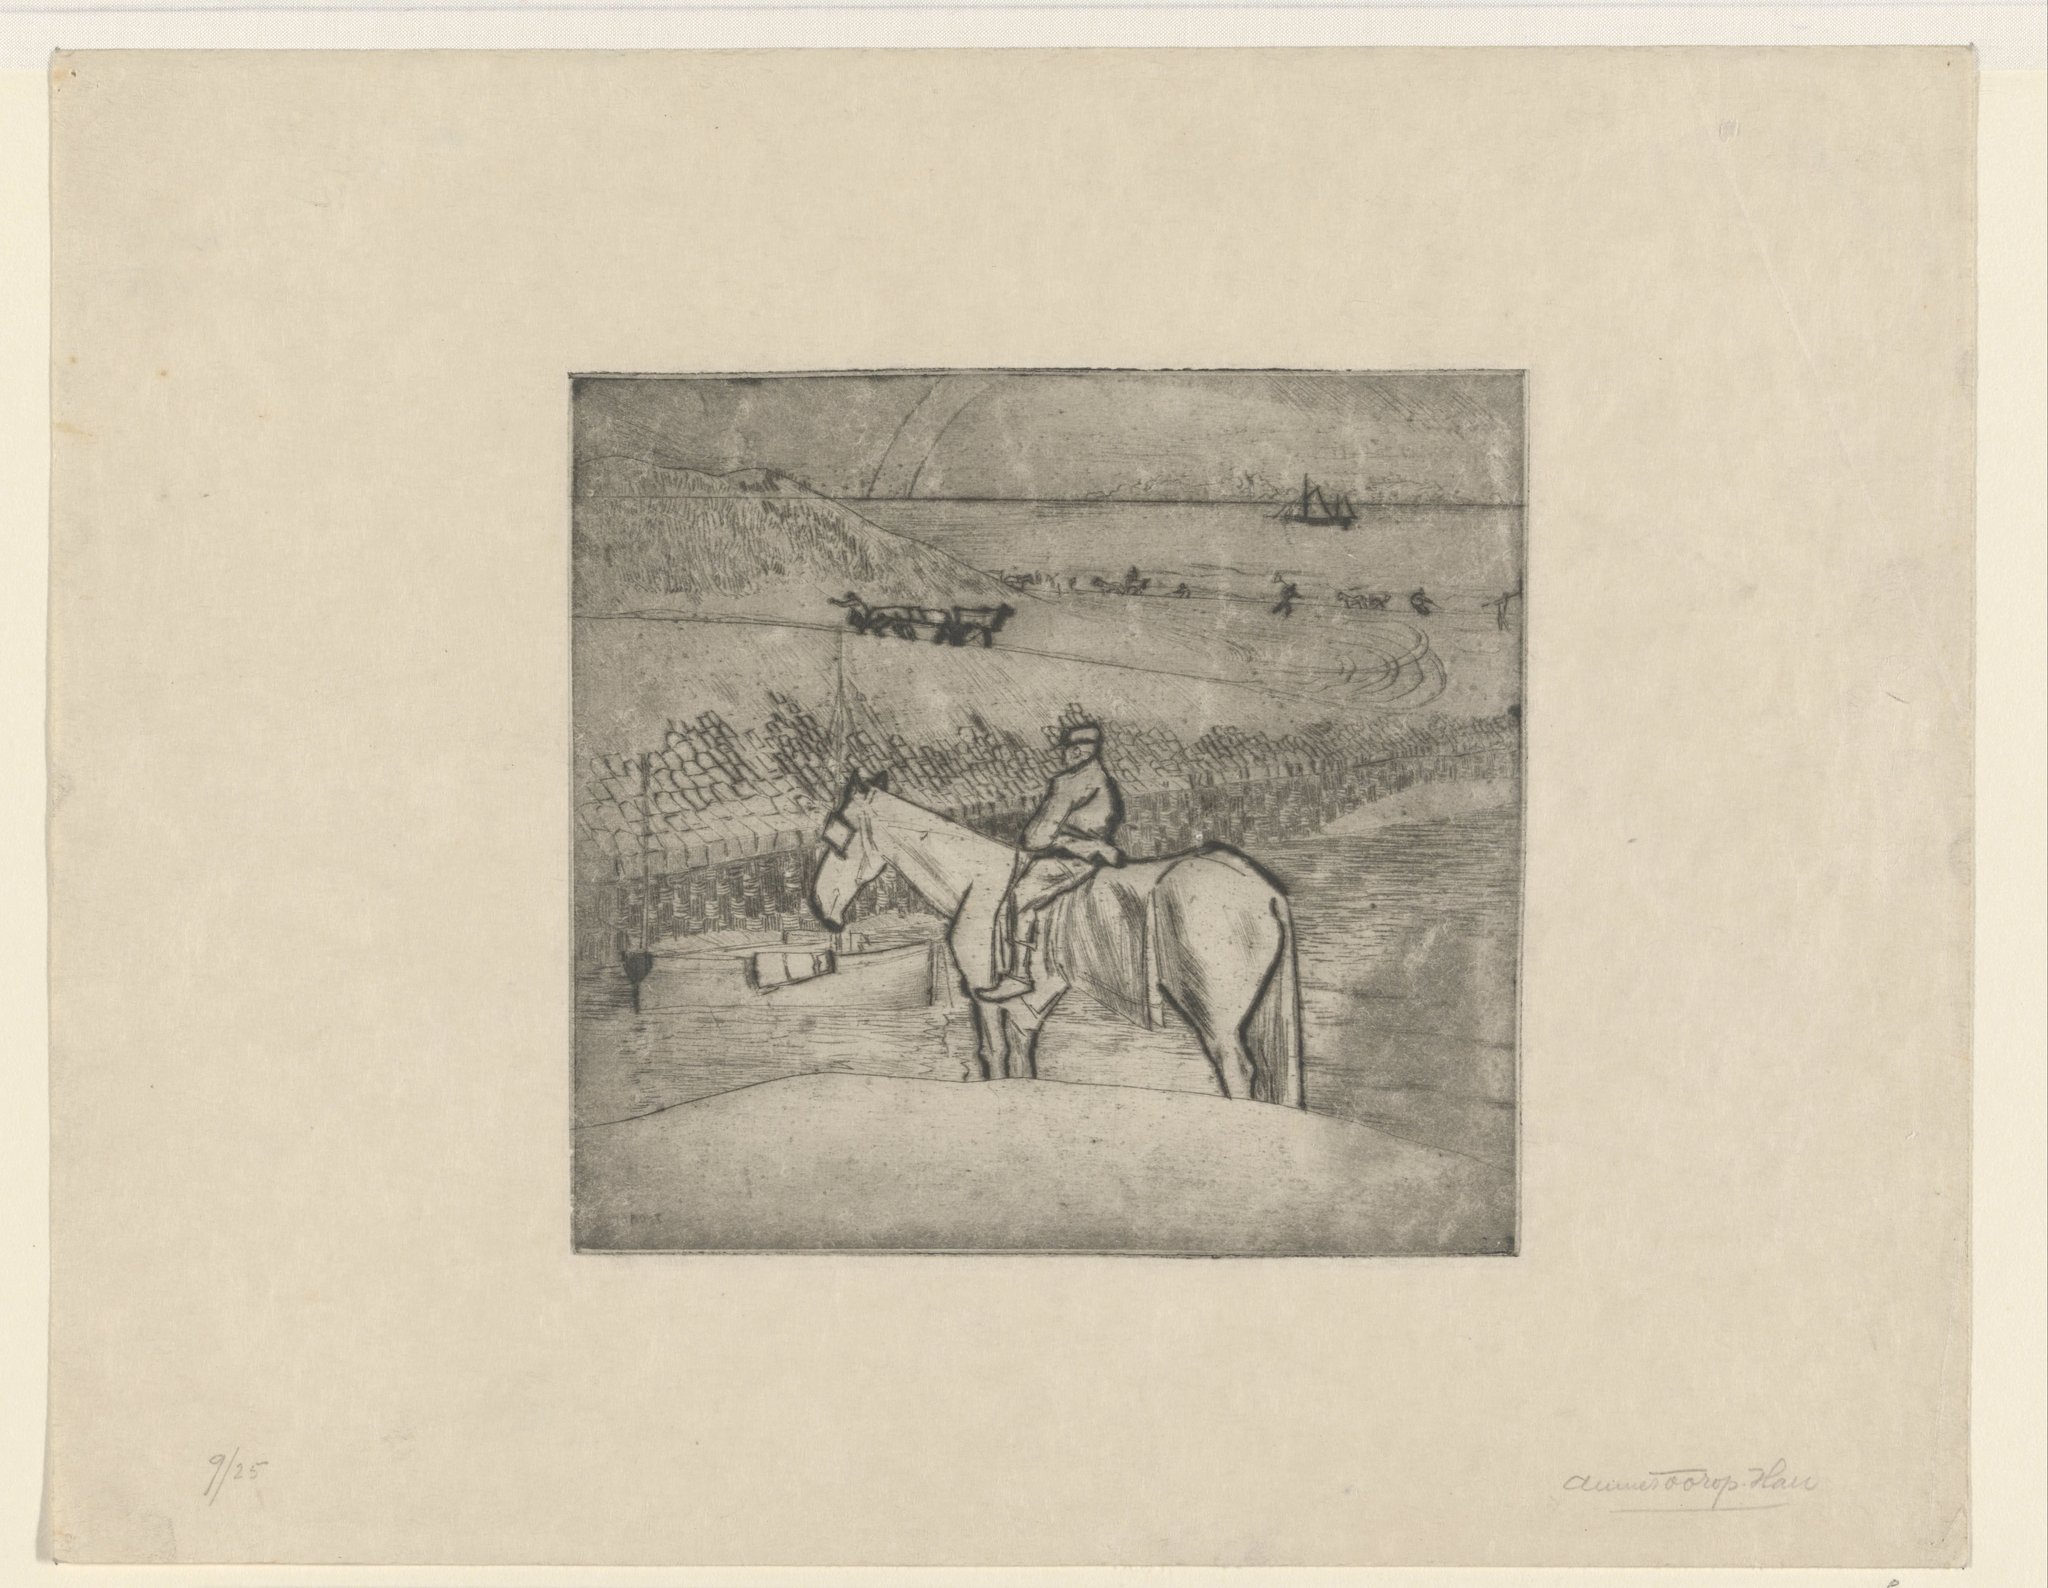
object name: print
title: Man op wit paard aan zee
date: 1898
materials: paper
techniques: drypoint, intaglio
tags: riding a horse, ass, or mule; rider, horseman, sea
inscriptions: signature: ‘Annie Toorop-Hall’, collector's mark: Lugt 2228